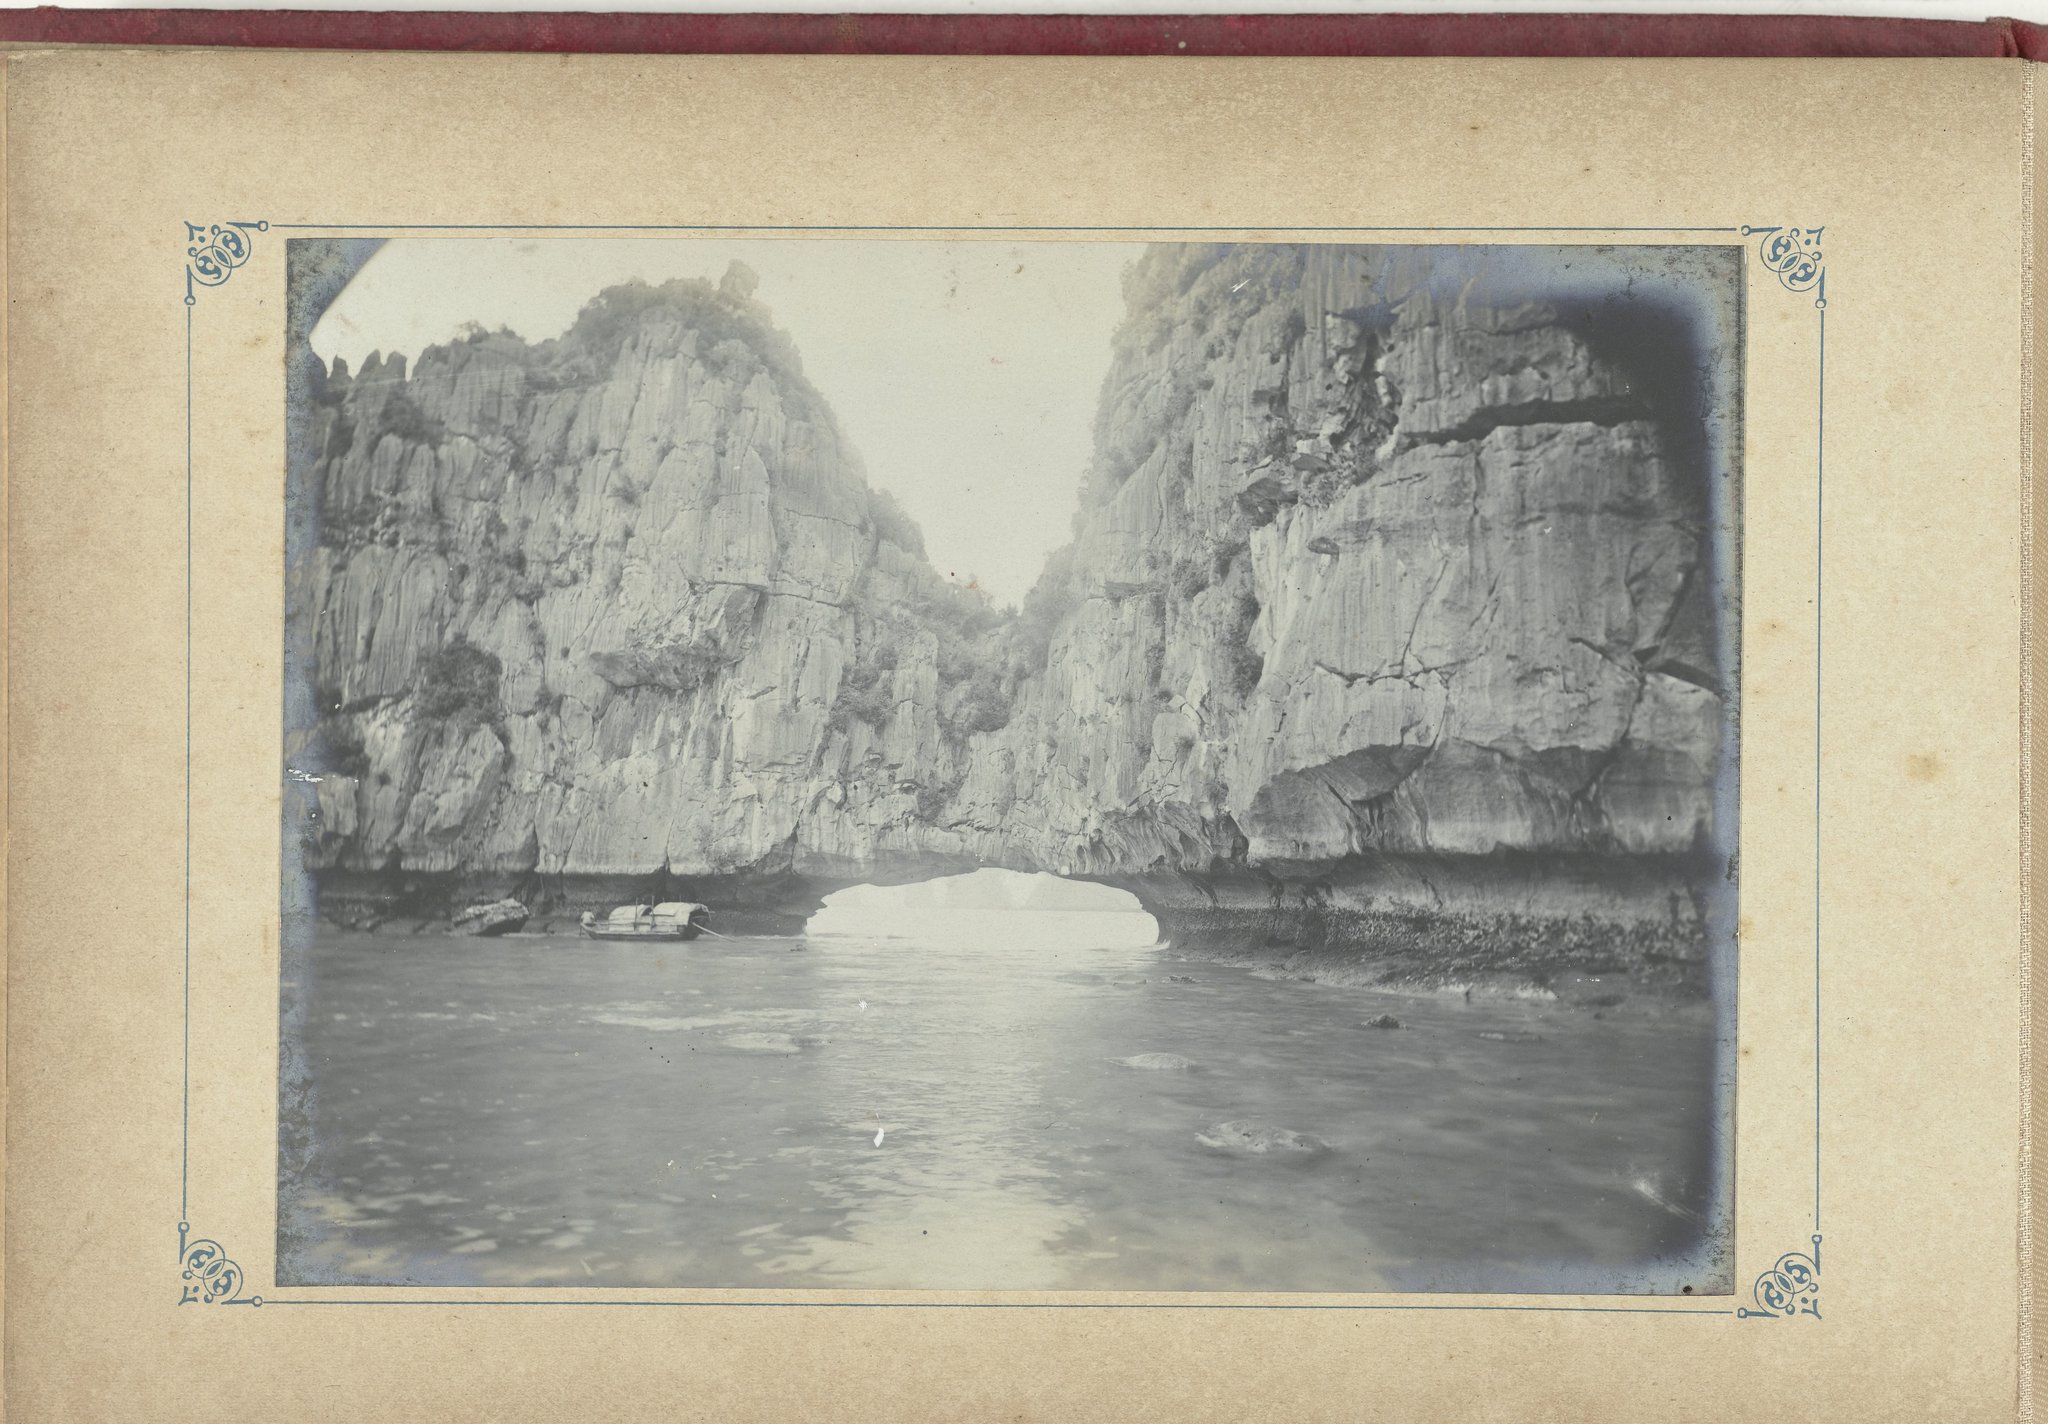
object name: photograph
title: Rotsen in de Ha Longbaai, Frans-Indochina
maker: Anonymous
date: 1902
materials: paper, cardboard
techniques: gelatin silver print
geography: vietnam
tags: island, rock-formations